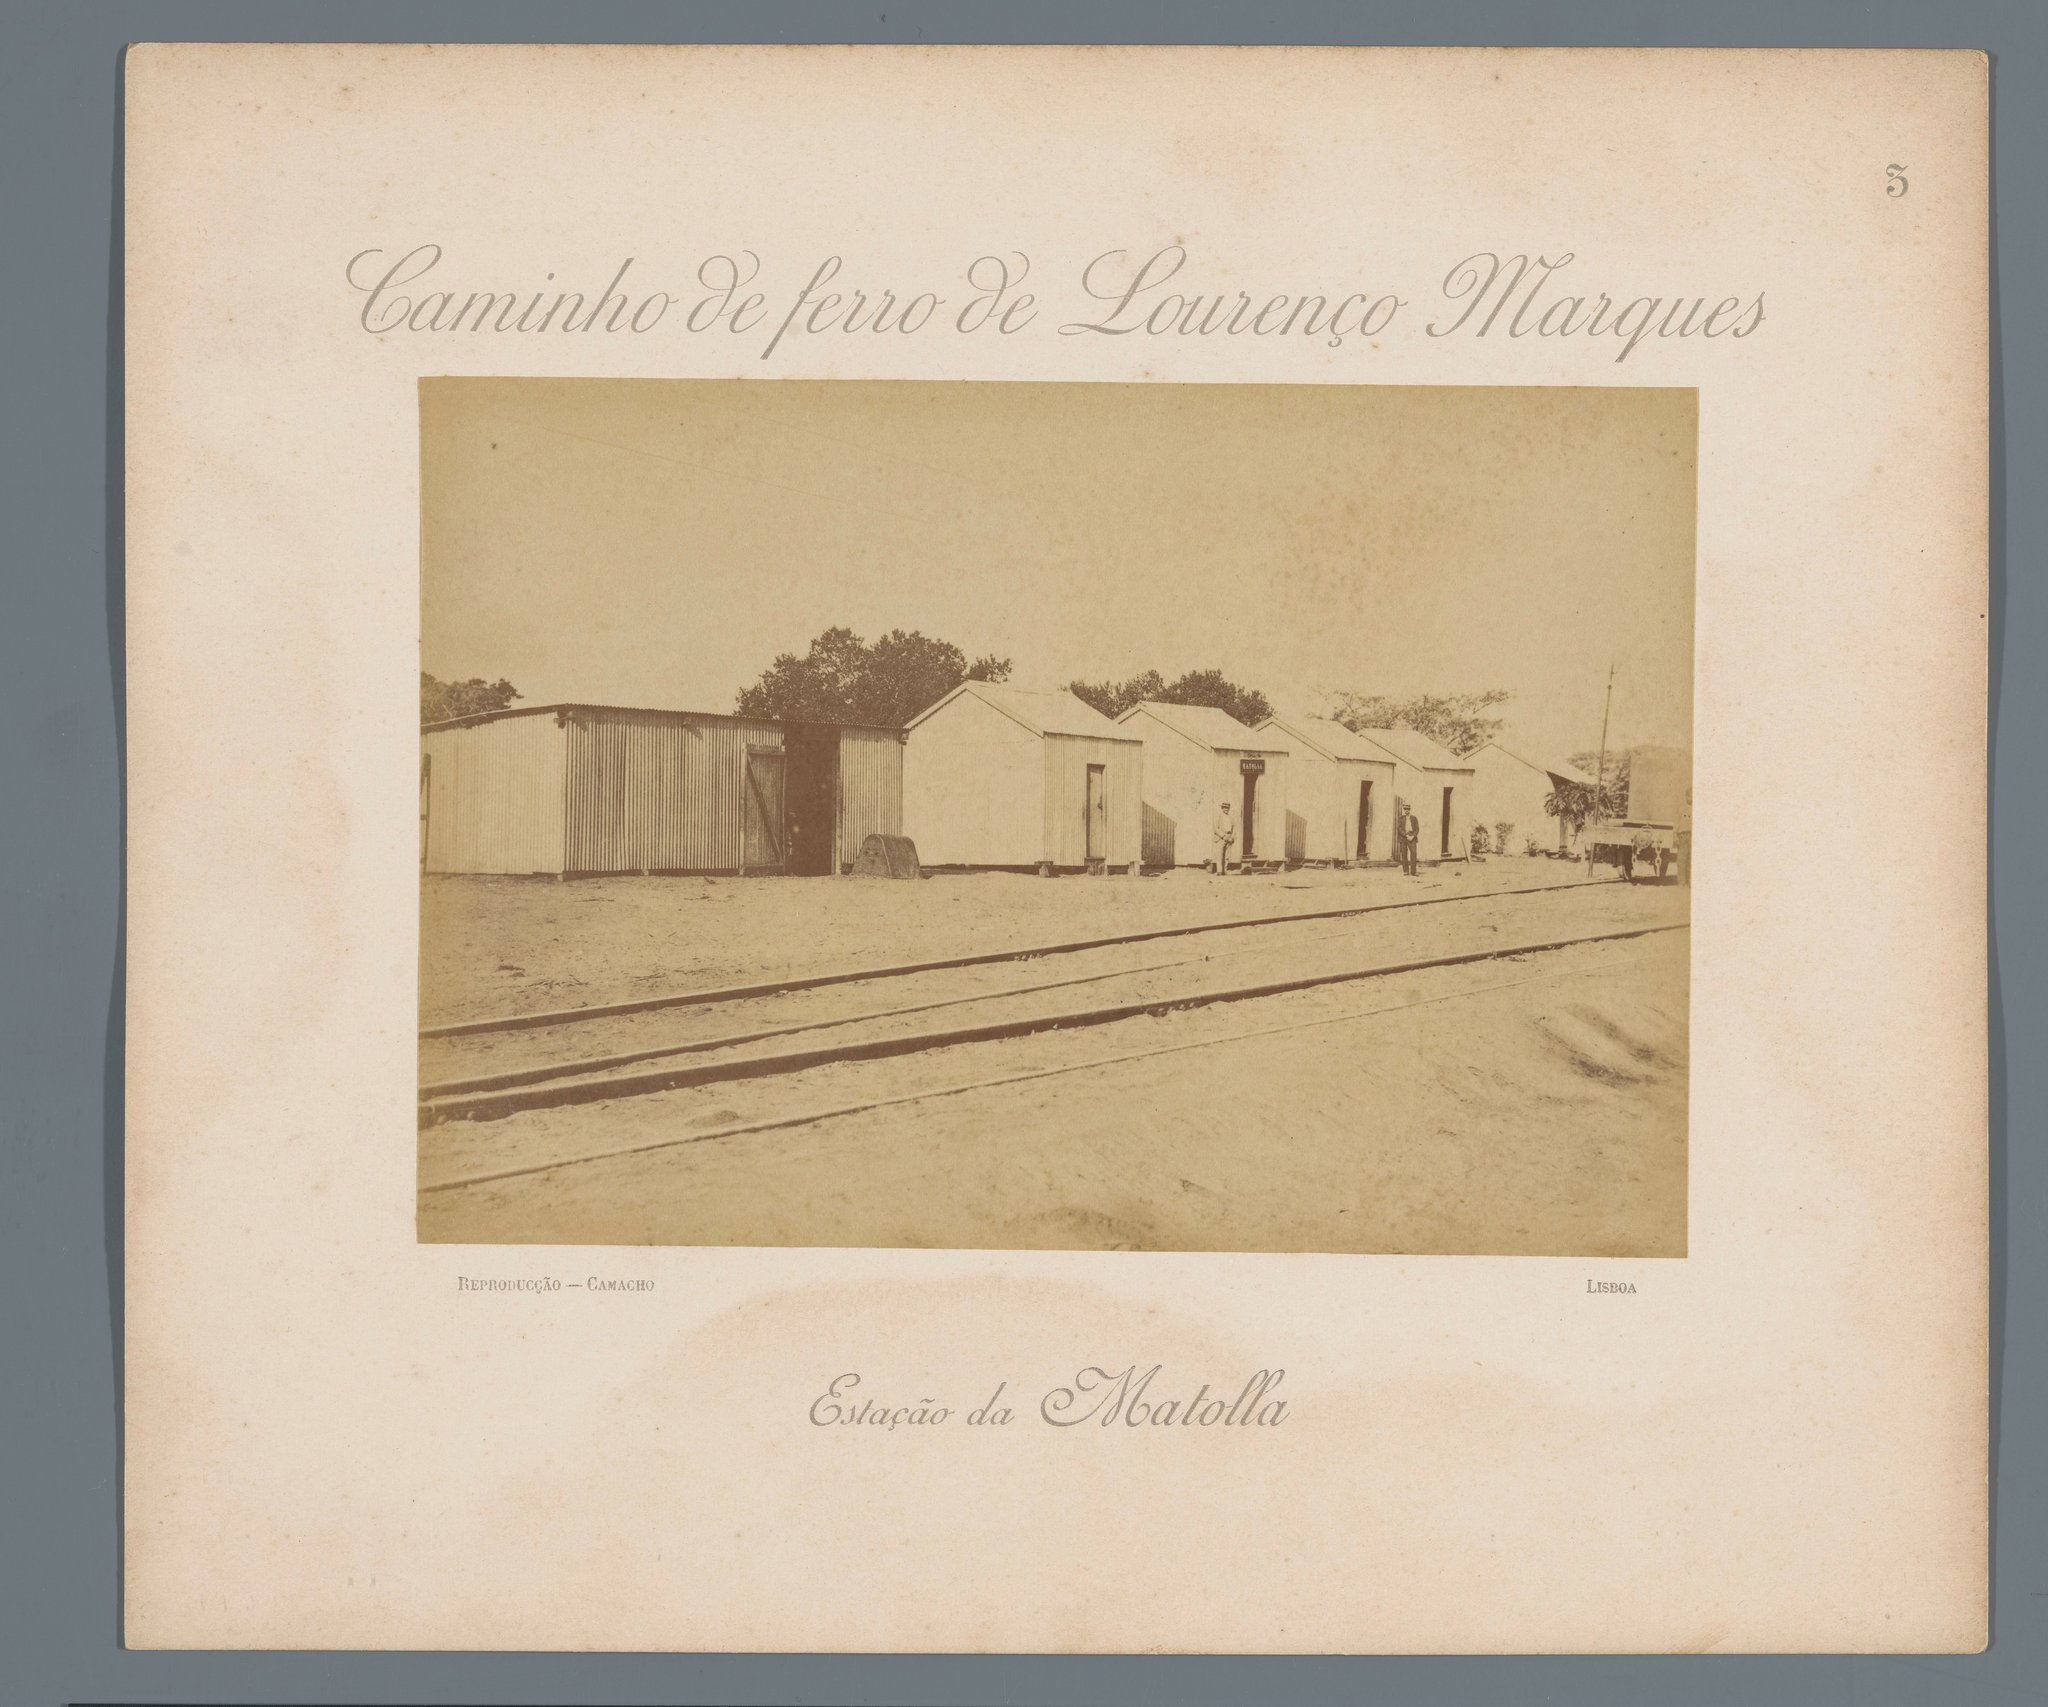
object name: page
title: Estação da Matolla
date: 1886-1895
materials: photographic support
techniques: albumen print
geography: lisbon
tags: railway, train, station; shelter (railway, tramway)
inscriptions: number: ‘3’